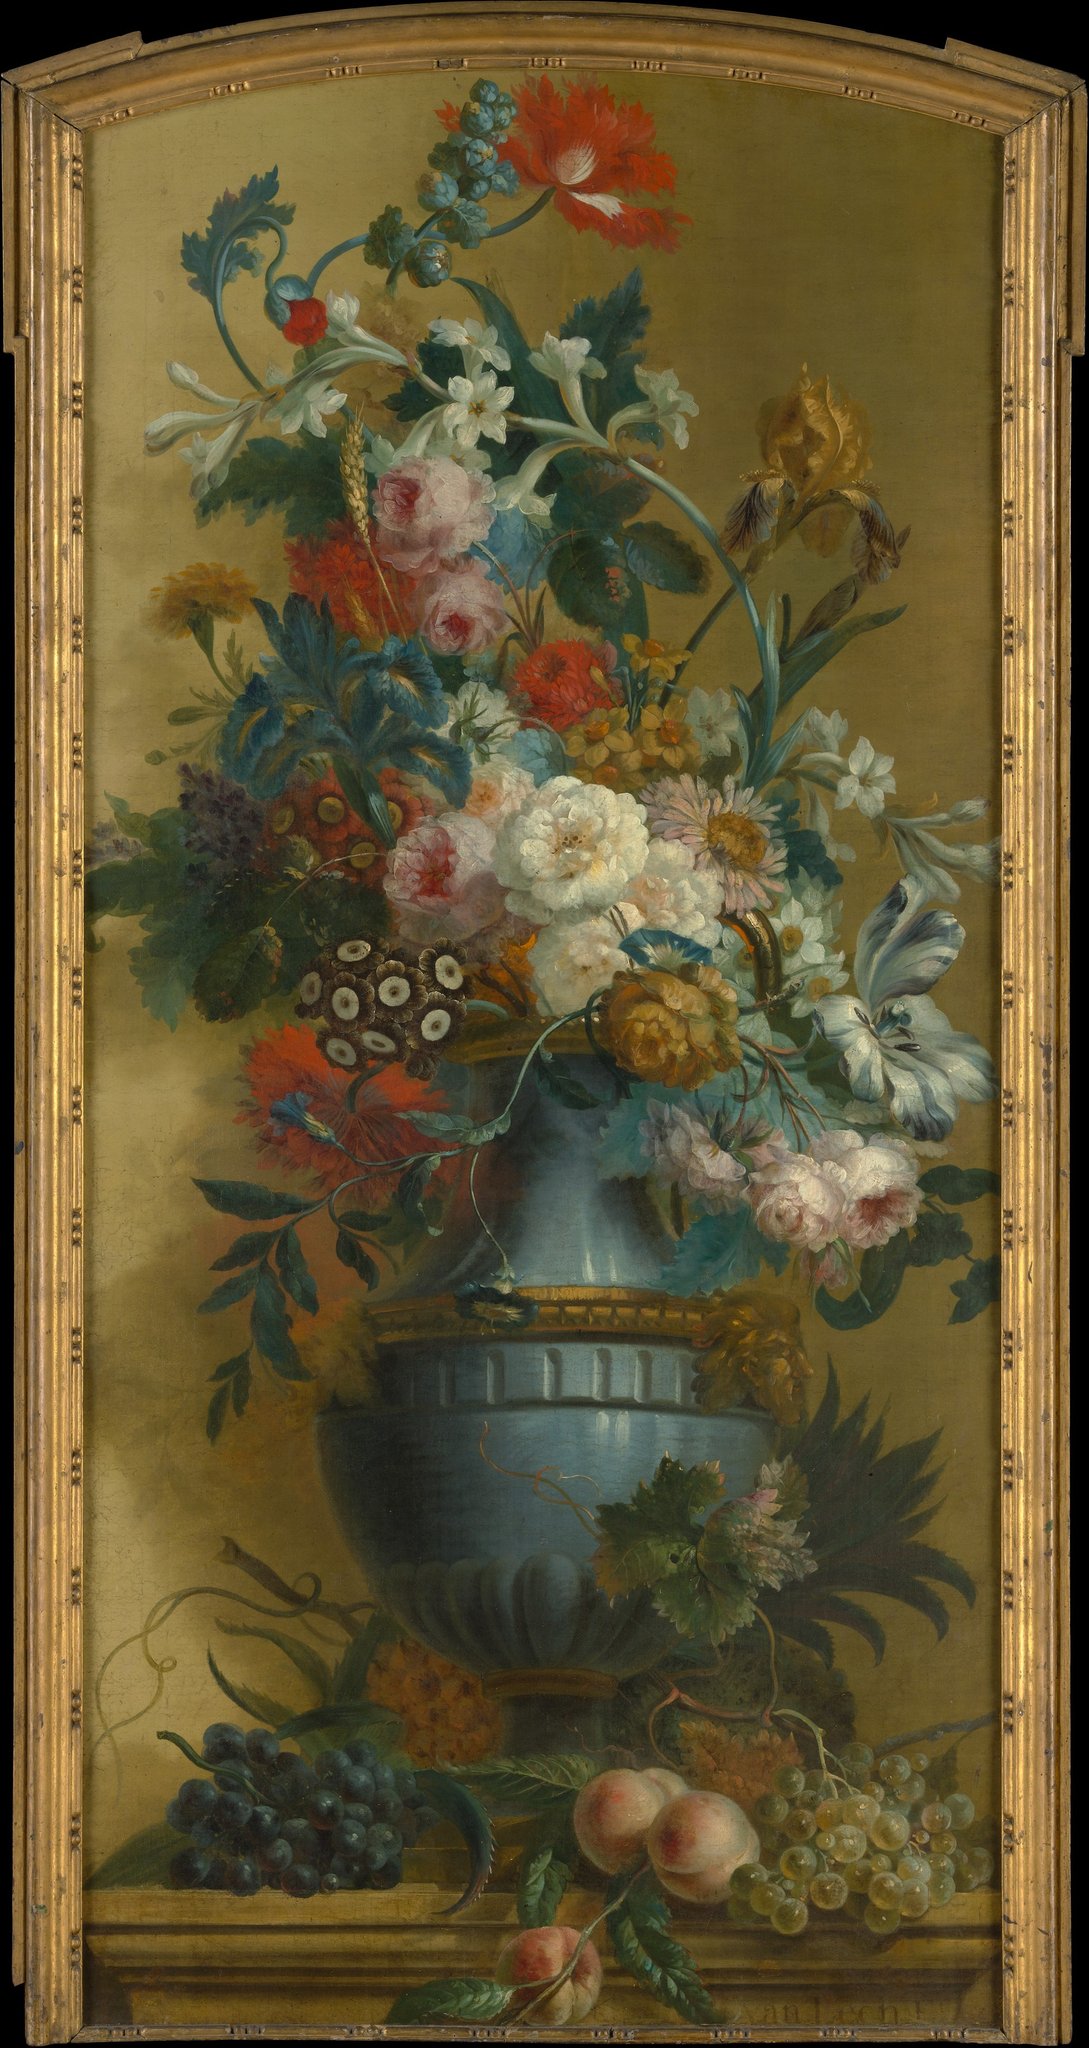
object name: painting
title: Flowers in a Blue Vase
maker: willem van leen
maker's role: artist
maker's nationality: dutch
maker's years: 1753-1825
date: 1701-1800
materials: canvas, oil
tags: grapes,peaches,flowers,still life